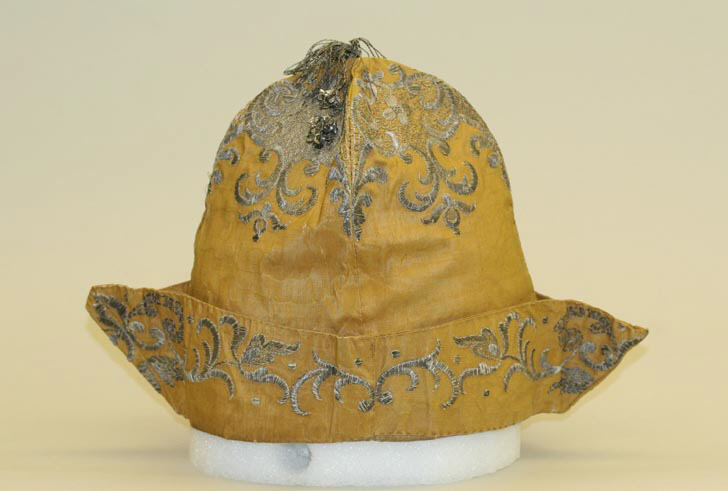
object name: cap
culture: italian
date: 1701-1733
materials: metal, silk